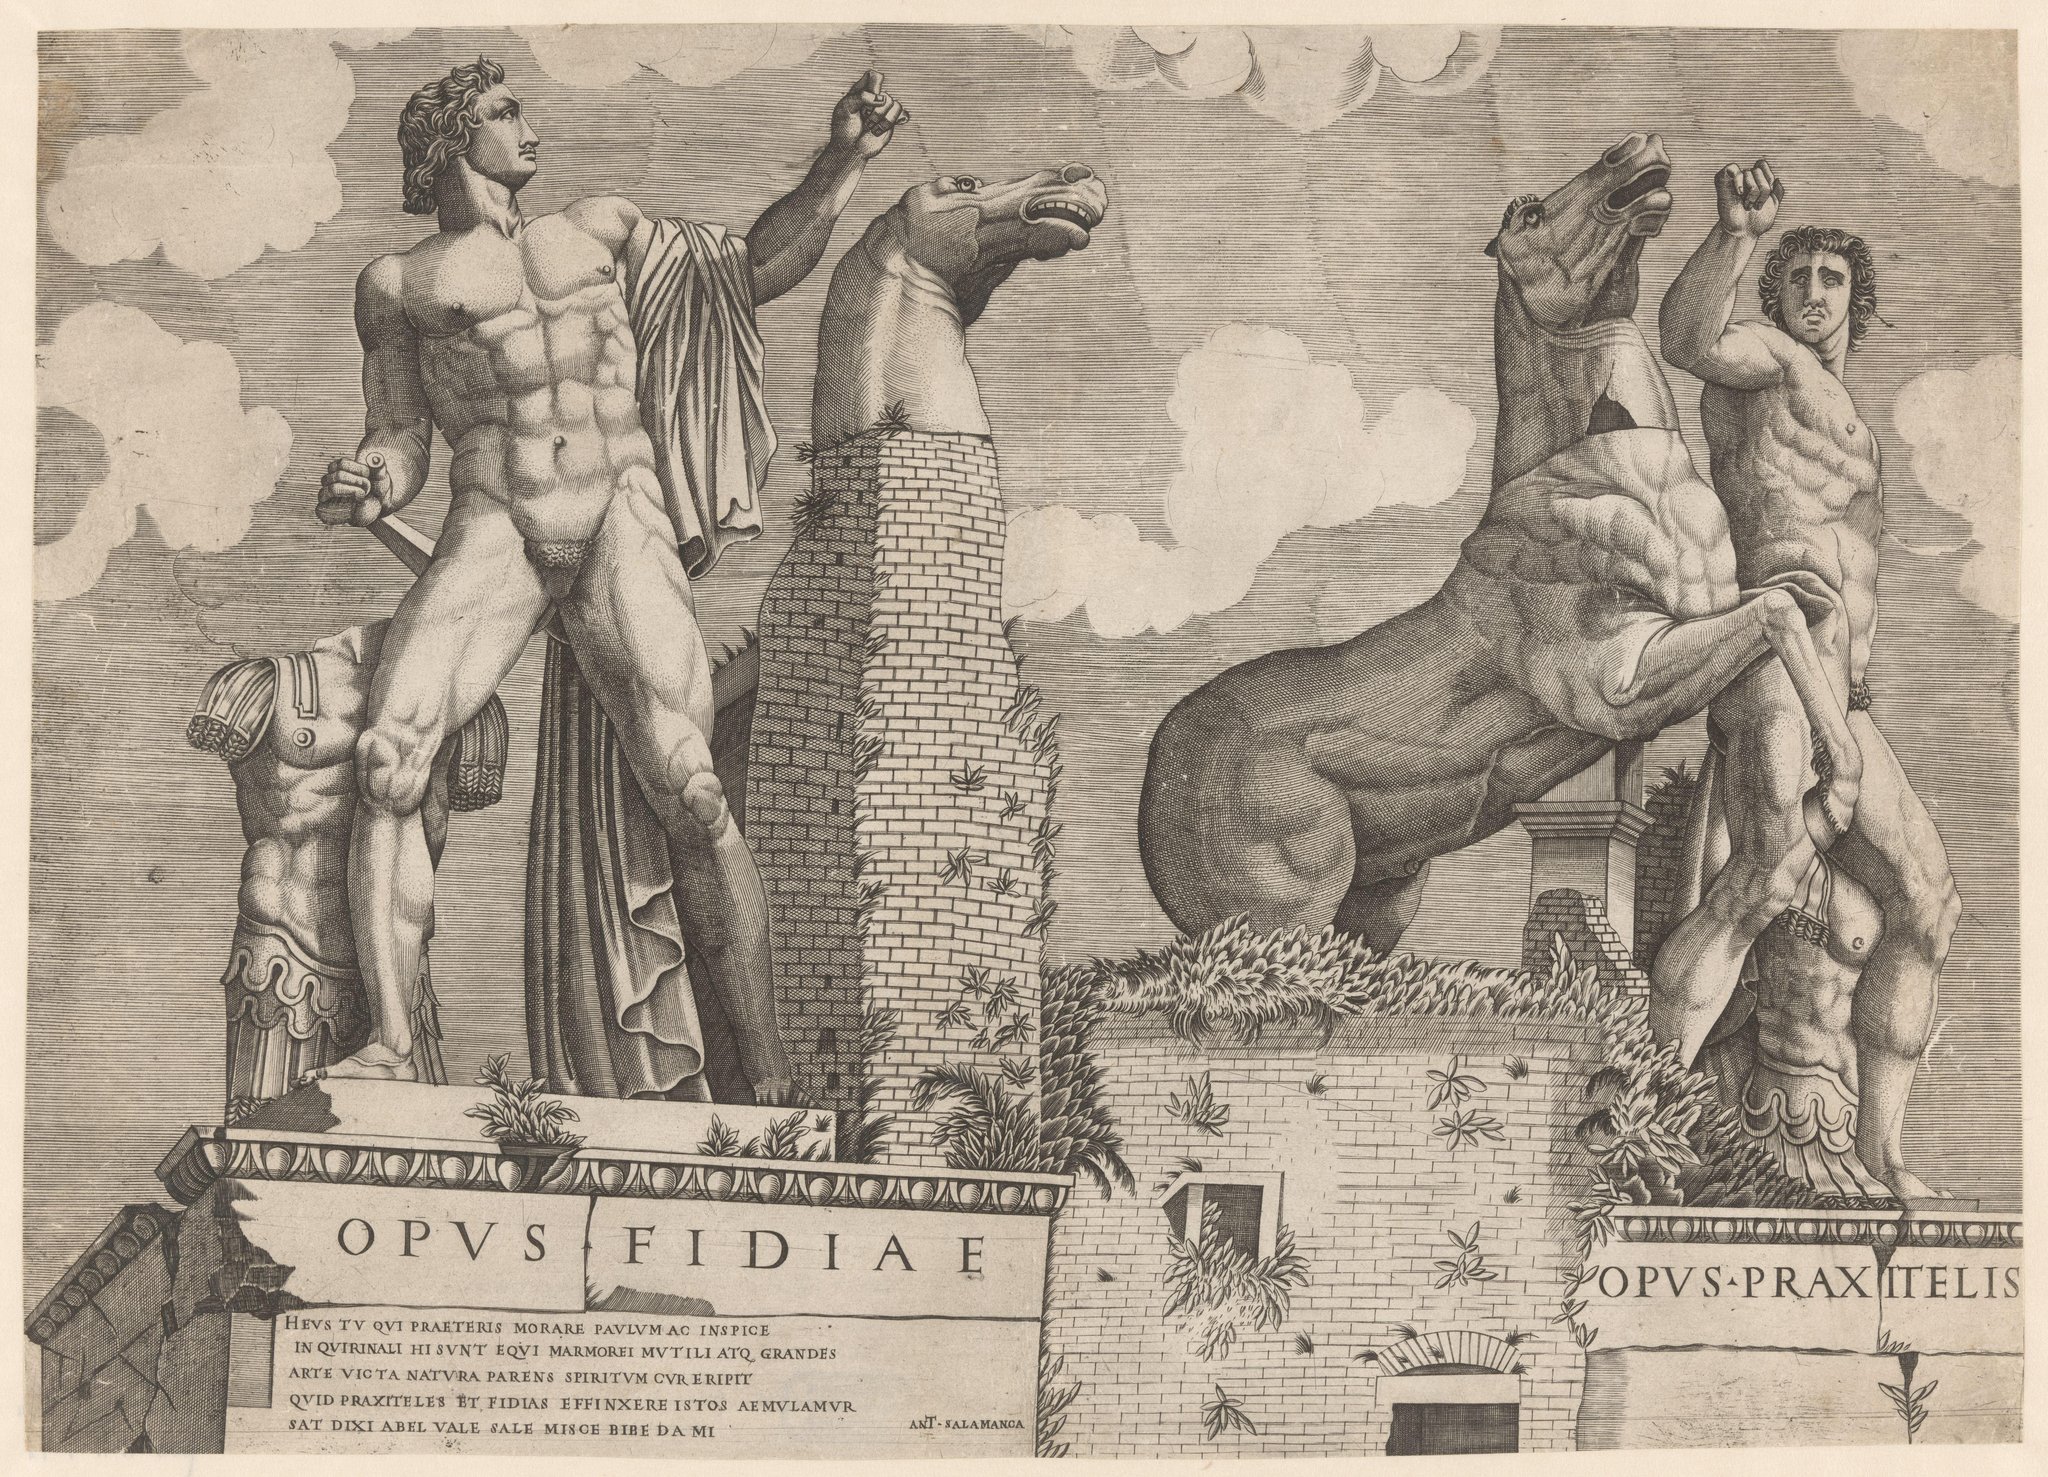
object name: print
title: Speculum Romanae Magnificentiae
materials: paper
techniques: engraving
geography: italy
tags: piece of sculpture, reproduction of a piece of sculpture, (story of) the dioscuri: castor (the horse-tamer) and pollux (the boxer)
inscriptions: collector's mark: Lugt 11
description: Deze prent behoort tot het prentcorpus dat bekend staat als de ‘Speculum Romanae Magnificentiae’ (‘Spiegel van Romeinse pracht’). Dit corpus, bestaande uit prenten met voorstellingen van kunstwerken en gebouwen uit het antieke en het moderne Rome, vond zijn oorsprong bij uitgevers Antonio Salamanca en Antonio Lafreri. Deze twee buitenlandse uitgevers bundelden hun krachten te Rome in de periode 1553-1563. Hun prenten werden al snel razend populair bij toeristen en verzamelaars, die de prenten individueel of in grote groepen aanschaften. Grote groepen Speculum-prenten werden vaak op aanvraag samengebonden in albums. Er zijn verschillende Speculum-albums overgeleverd die allemaal verschillen van inhoud. Tussen 1573 en 1577 gaf Antonio Lafreri een speciale titelpagina uit (met de titel ‘Speculum Romanae Magnificentiae’) die mensen voor hun verzamelingen konden voegen. Het overlijden van Lafreri in 1577 betekende niet het einde van het corpus. Een groot deel van de koperplaten ging over op Claudio en Stefano Duchetti. De rest raakte verspreid over verschillende andere uitgevers. De populariteit van de Speculum-prenten wist nog geruime periode uitgevers te inspireren tot het laten maken van kopieën en het toevoegen van nieuwe prenten aan het corpus.